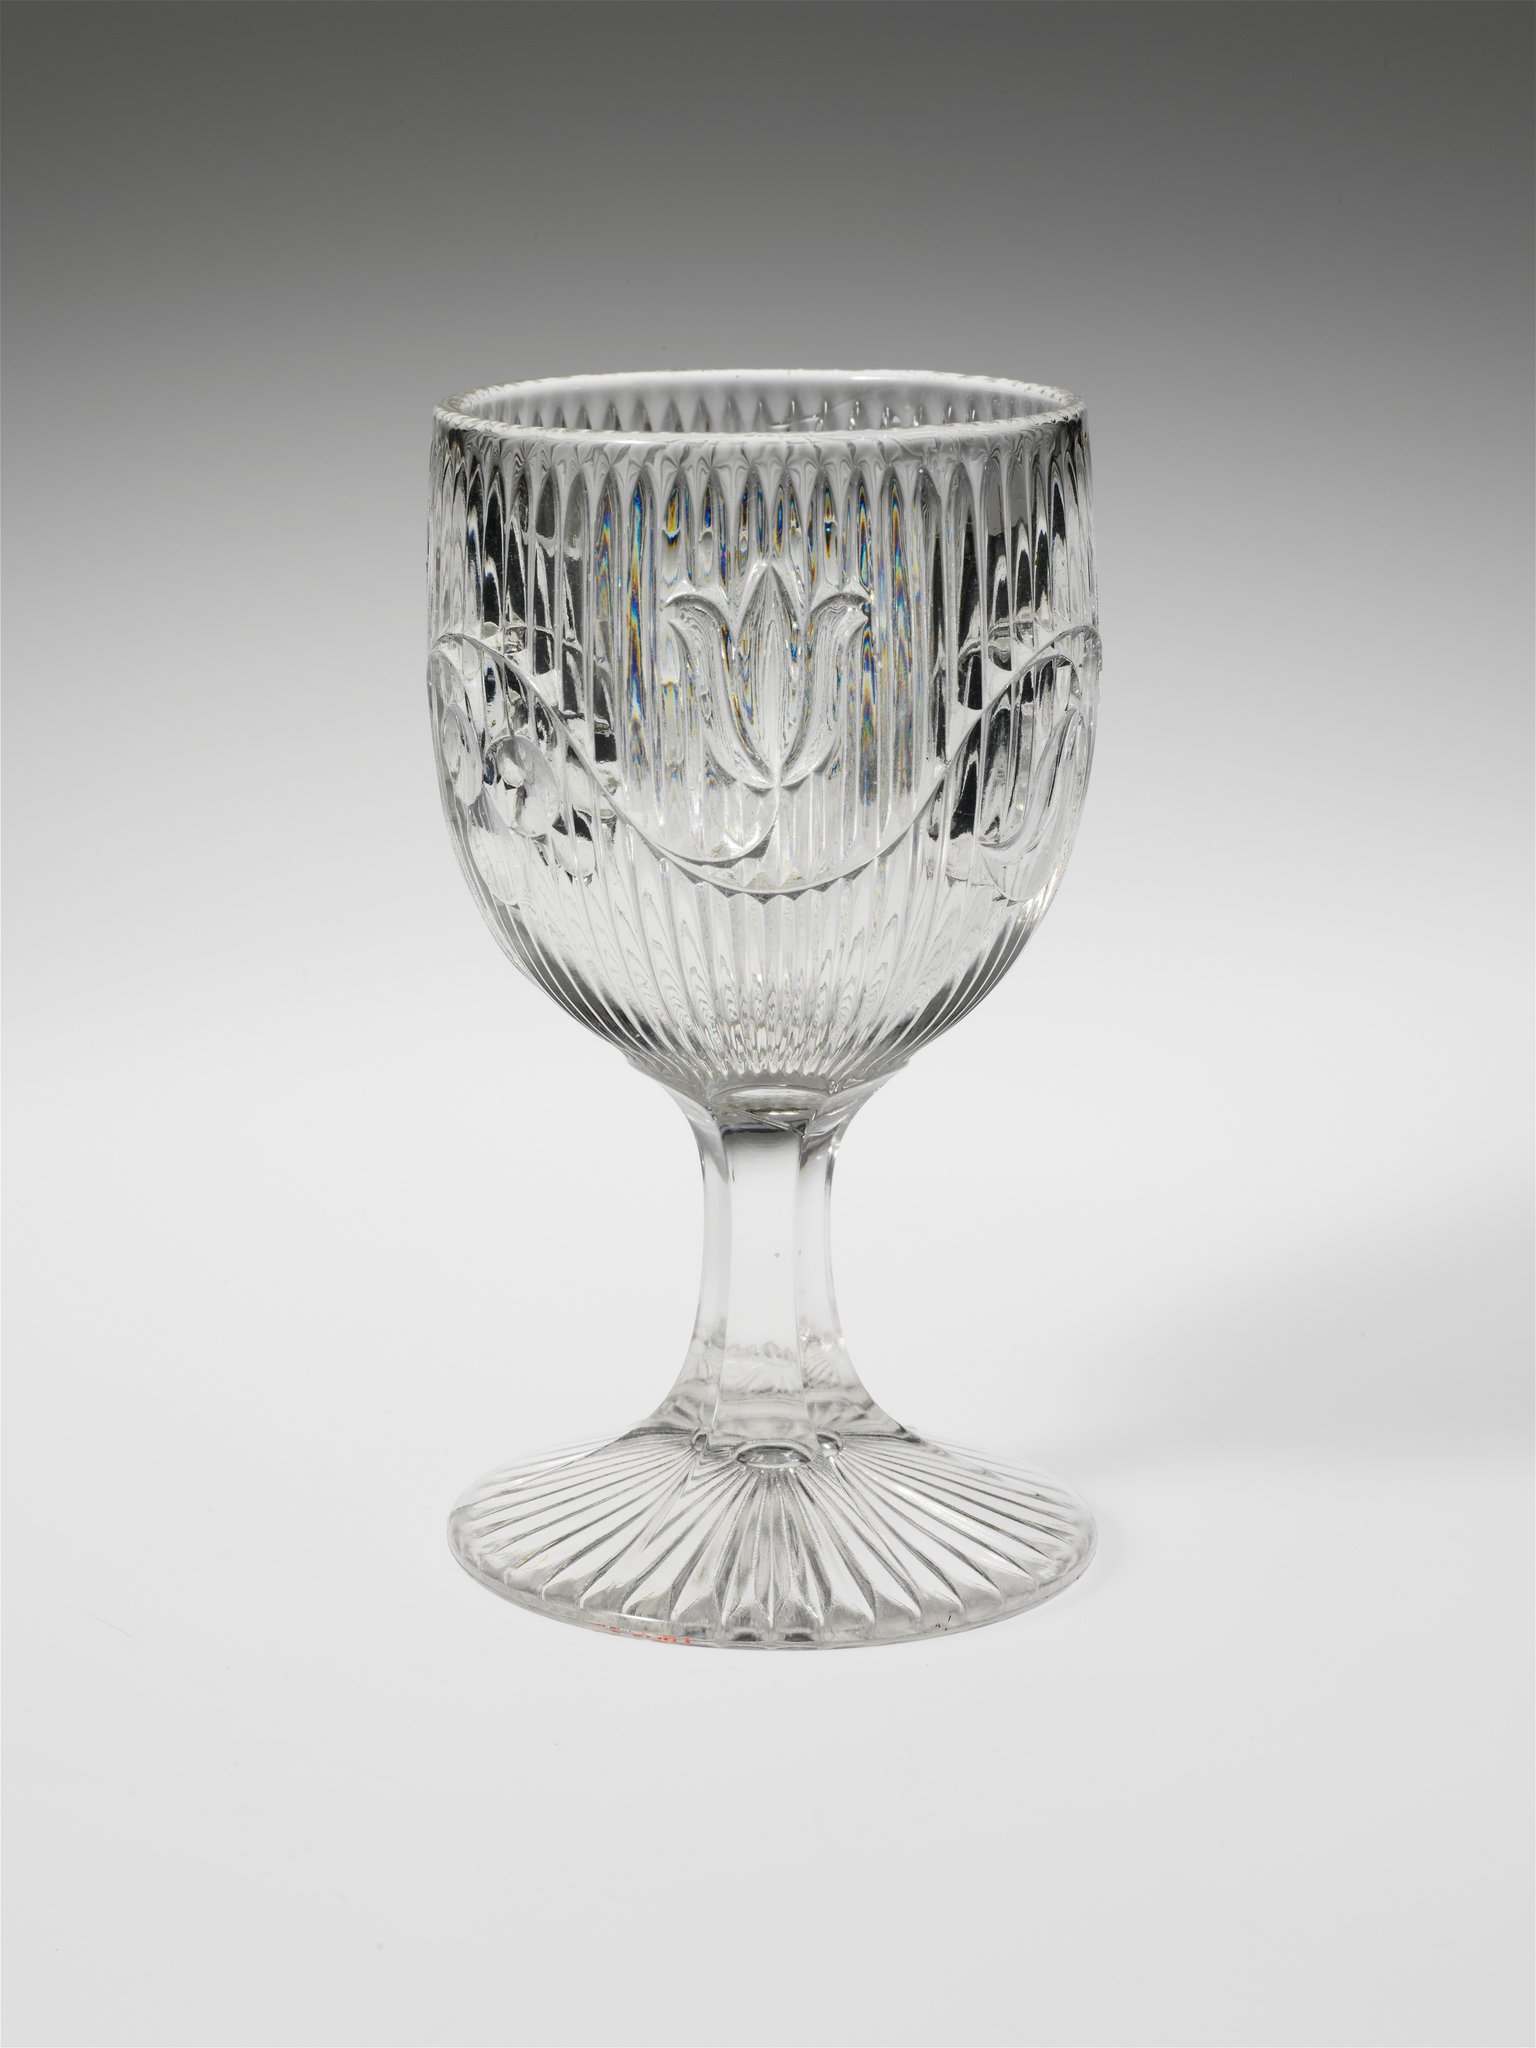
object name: goblet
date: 1850-1870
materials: glass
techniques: pressed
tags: flowers